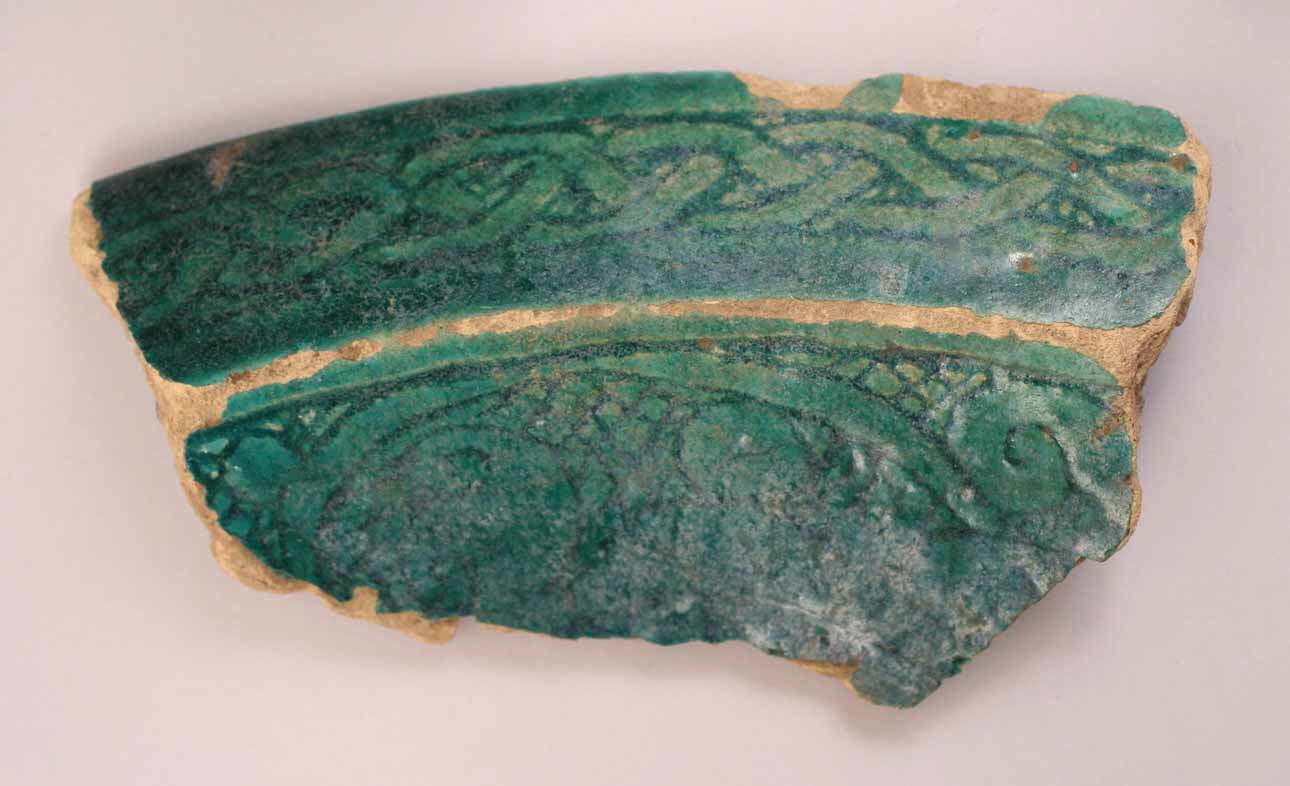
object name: ceramic fragment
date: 1301-1500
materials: earthenware, glaze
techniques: incising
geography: egypt